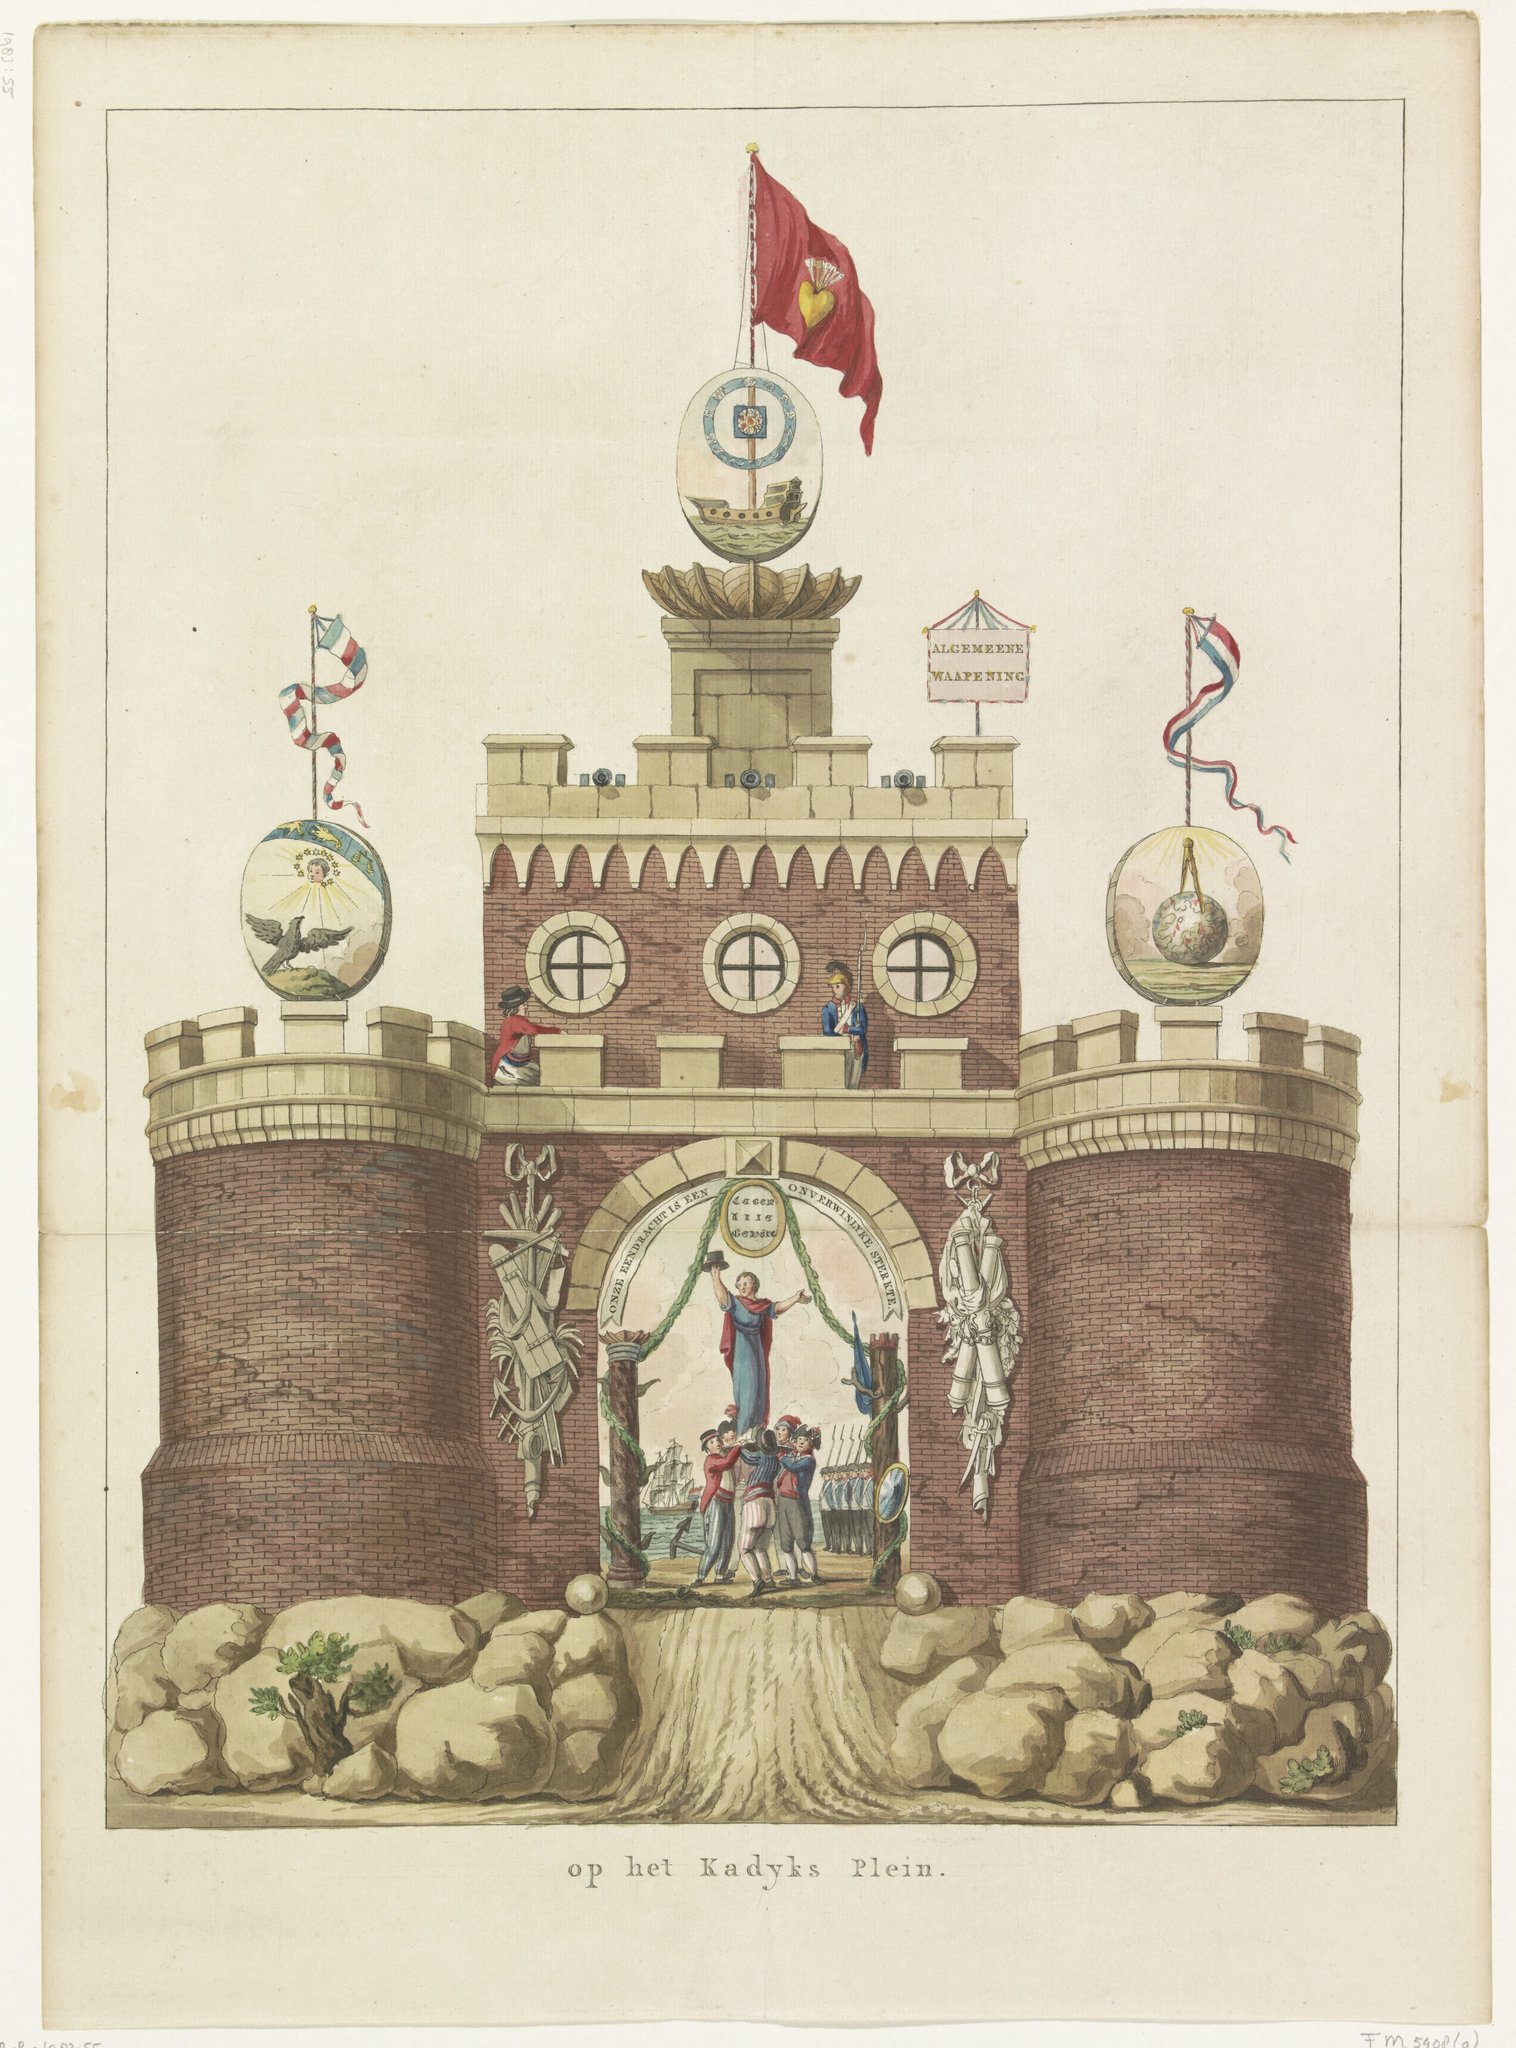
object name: print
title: Algemeene Waapening / op het Kadyks Plein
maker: Anonymous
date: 1795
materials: paper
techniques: etching, hand coloring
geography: netherlands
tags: fortress, new ruler raised on the shield, freedom, liberty; 'libertà' (ripa) (+ abstract concept represented by female figure), festivities on events of national importance (+ festive decoration ~ festive activities), amsterdam, alliance with france (1795)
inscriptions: collector's mark: Lugt 2228, collector's mark: Lugt 2760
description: De Algemene Wapening, allegorische decoratie opgericht op het Kadijksplein te Amsterdam bij het Alliantiefeest op 19 juni 1795. Middeleeuwse burcht staande op rotsen, op de torens symbolen van de astronomie, hydrografie en geometrie, Op het chassinet in de onderdoorgang wordt de Vrijheid door Bataafse en Franse matrozen op een schild gehezen.